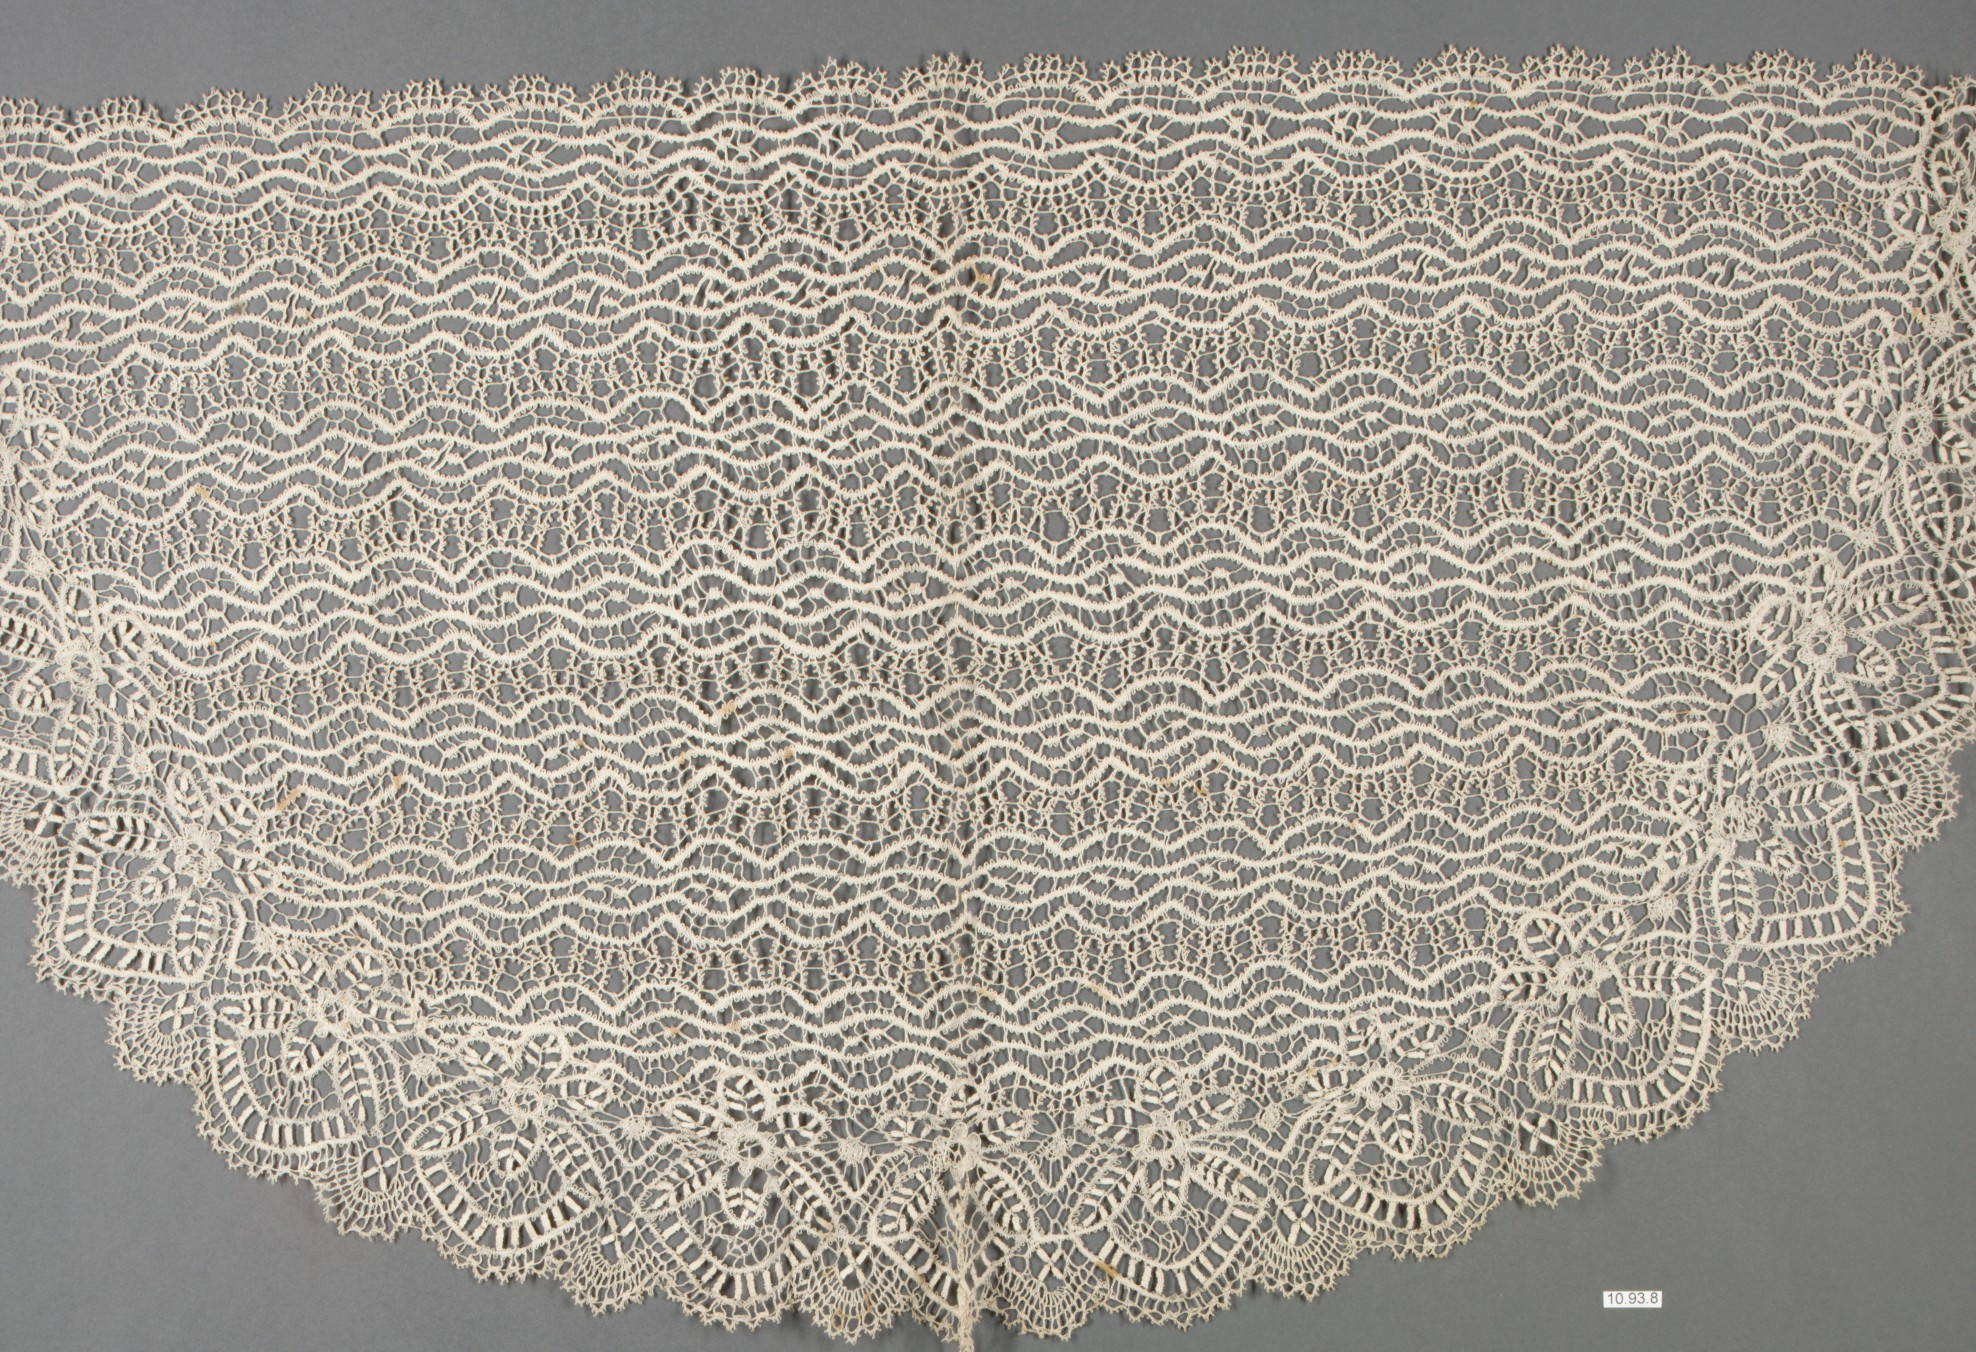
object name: veil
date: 1801-1833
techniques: lace